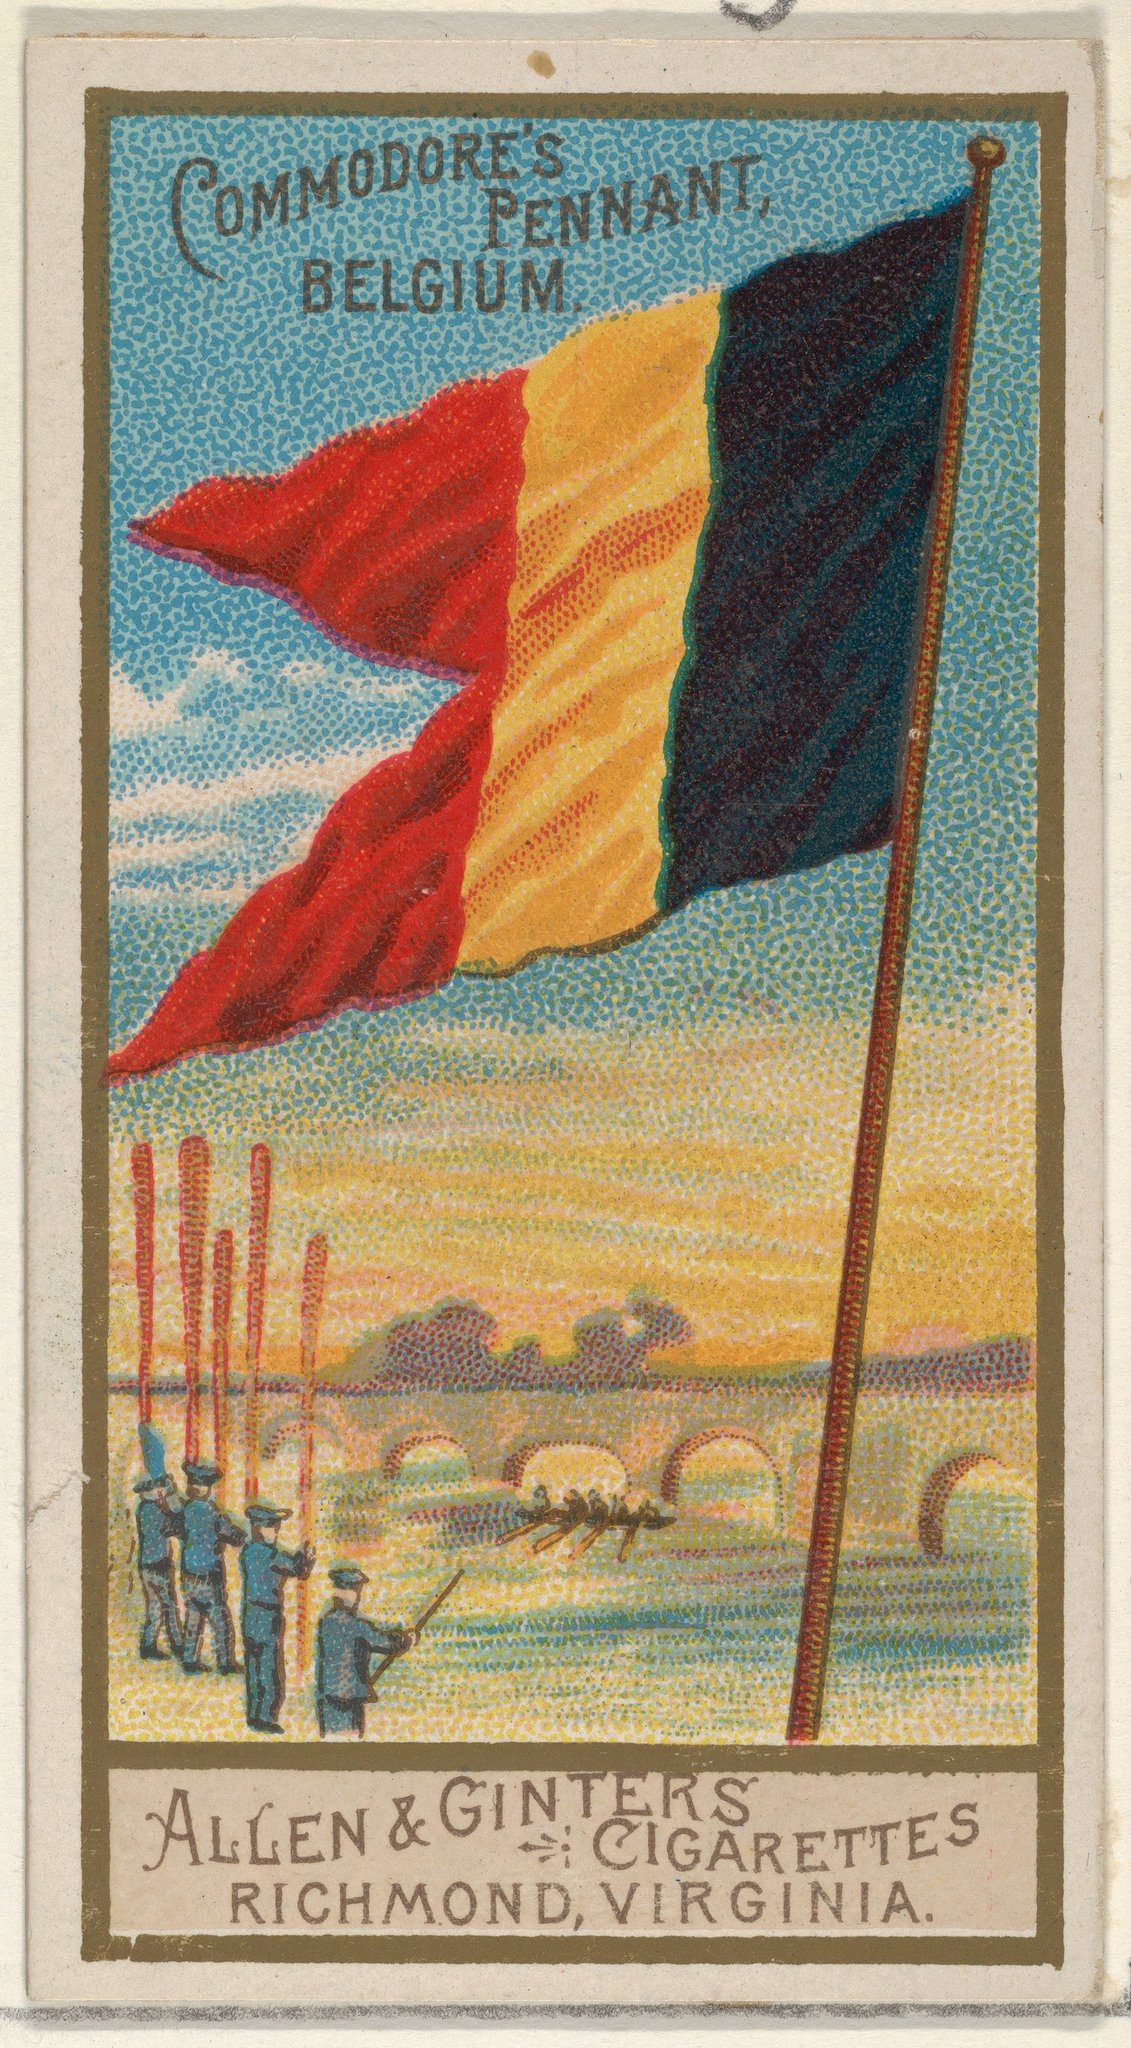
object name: print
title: Commodore's Pennant, Belgium, from the Naval Flags series (N17) for Allen & Ginter Cigarettes Brands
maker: allen & ginter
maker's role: publisher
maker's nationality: american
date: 1888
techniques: color lithograph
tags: flags